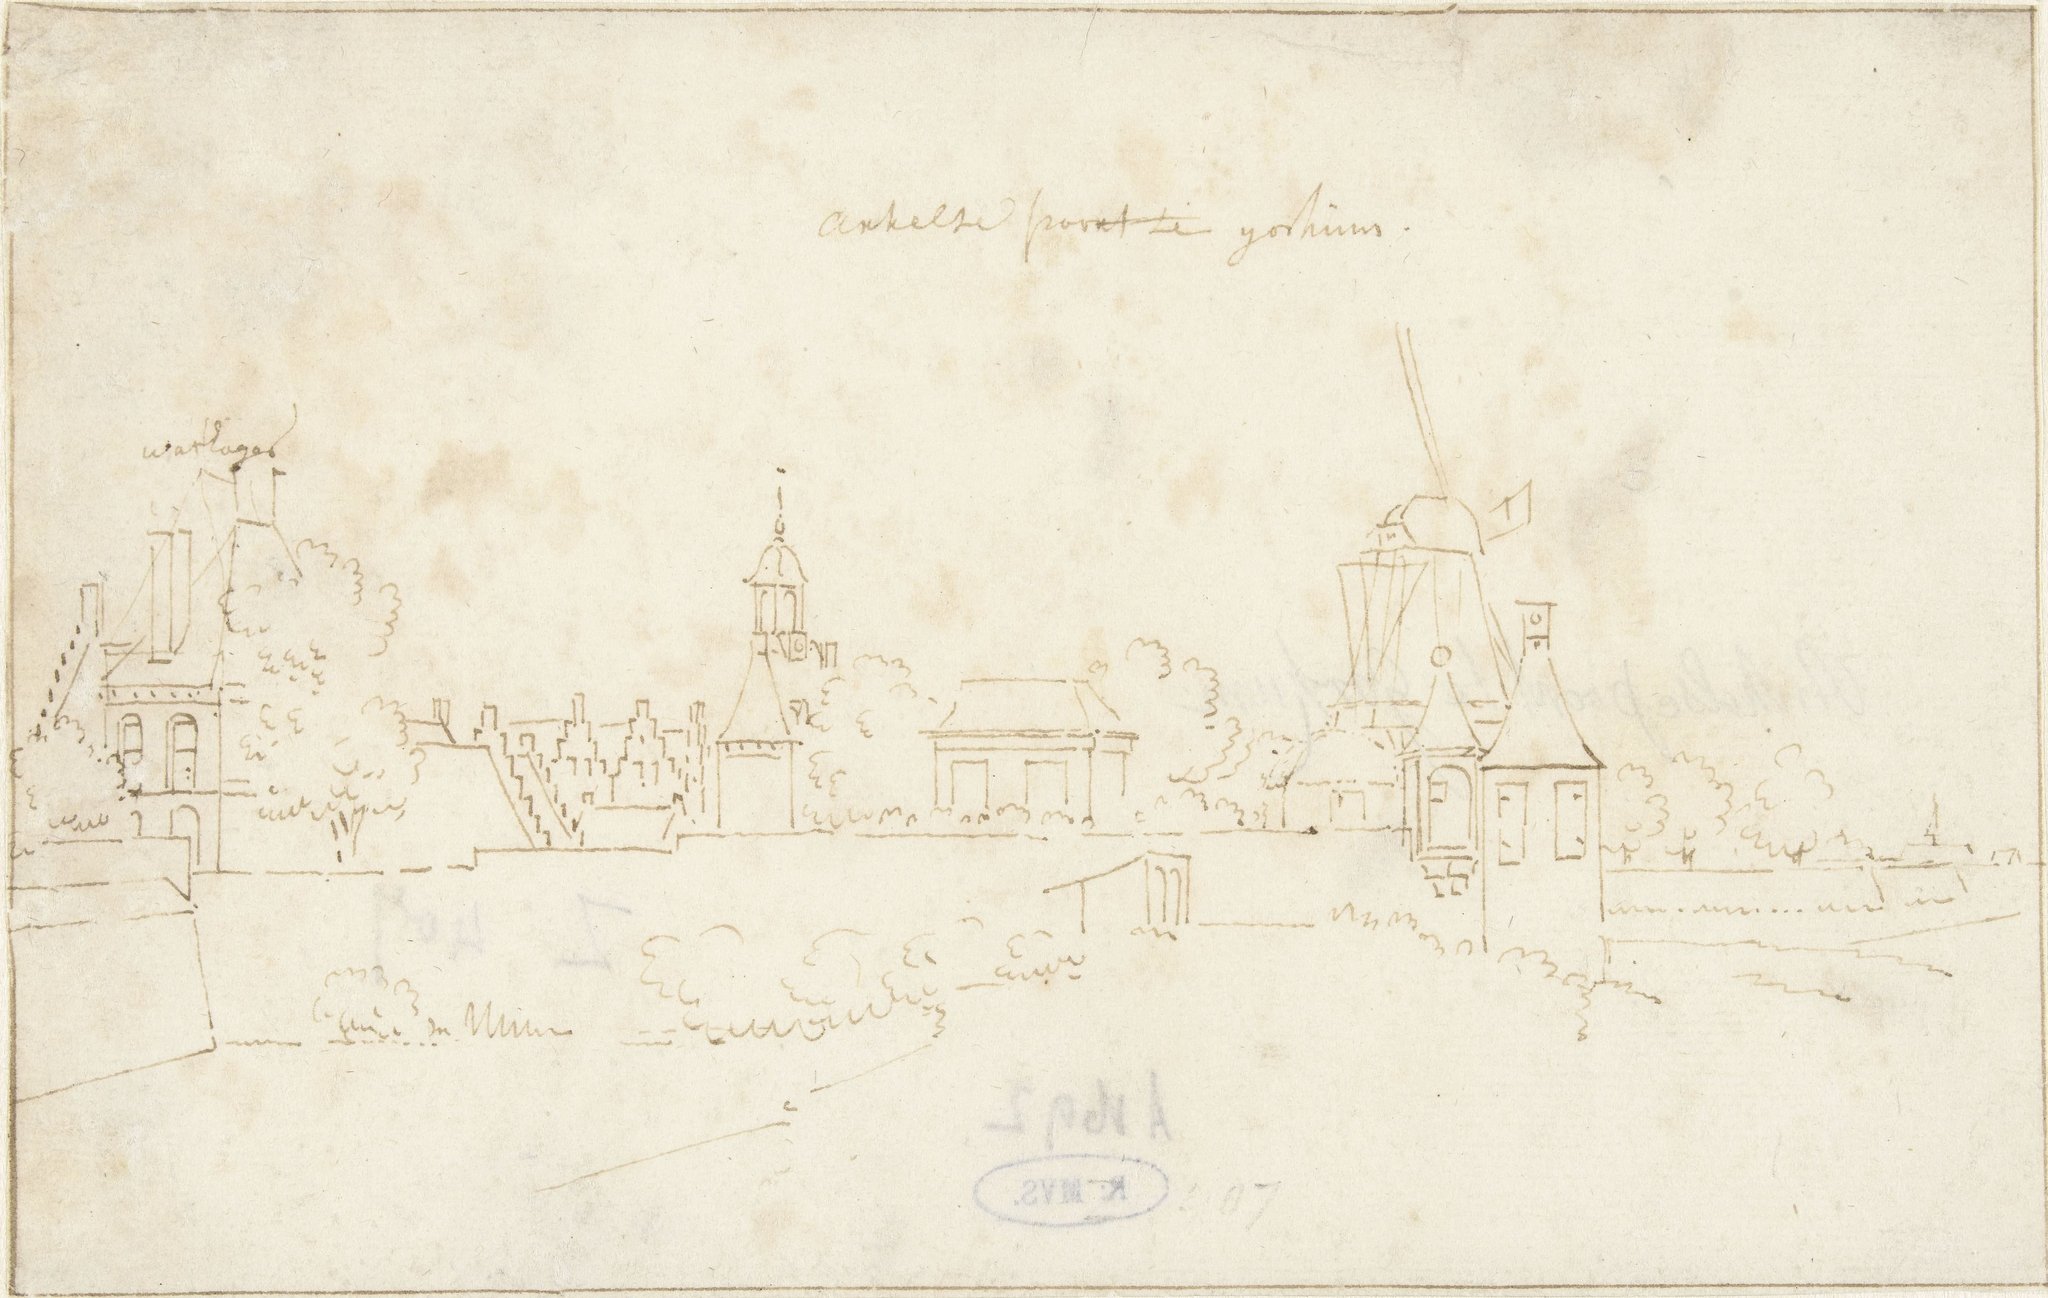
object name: drawing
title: Stadswallen van Gorinchem met een molen en de Arkelse poort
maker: cornelis pronk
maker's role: draughtsman, painter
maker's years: 1691-1759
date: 1701-1759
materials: ink, paper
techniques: pen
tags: windmill, city-gate